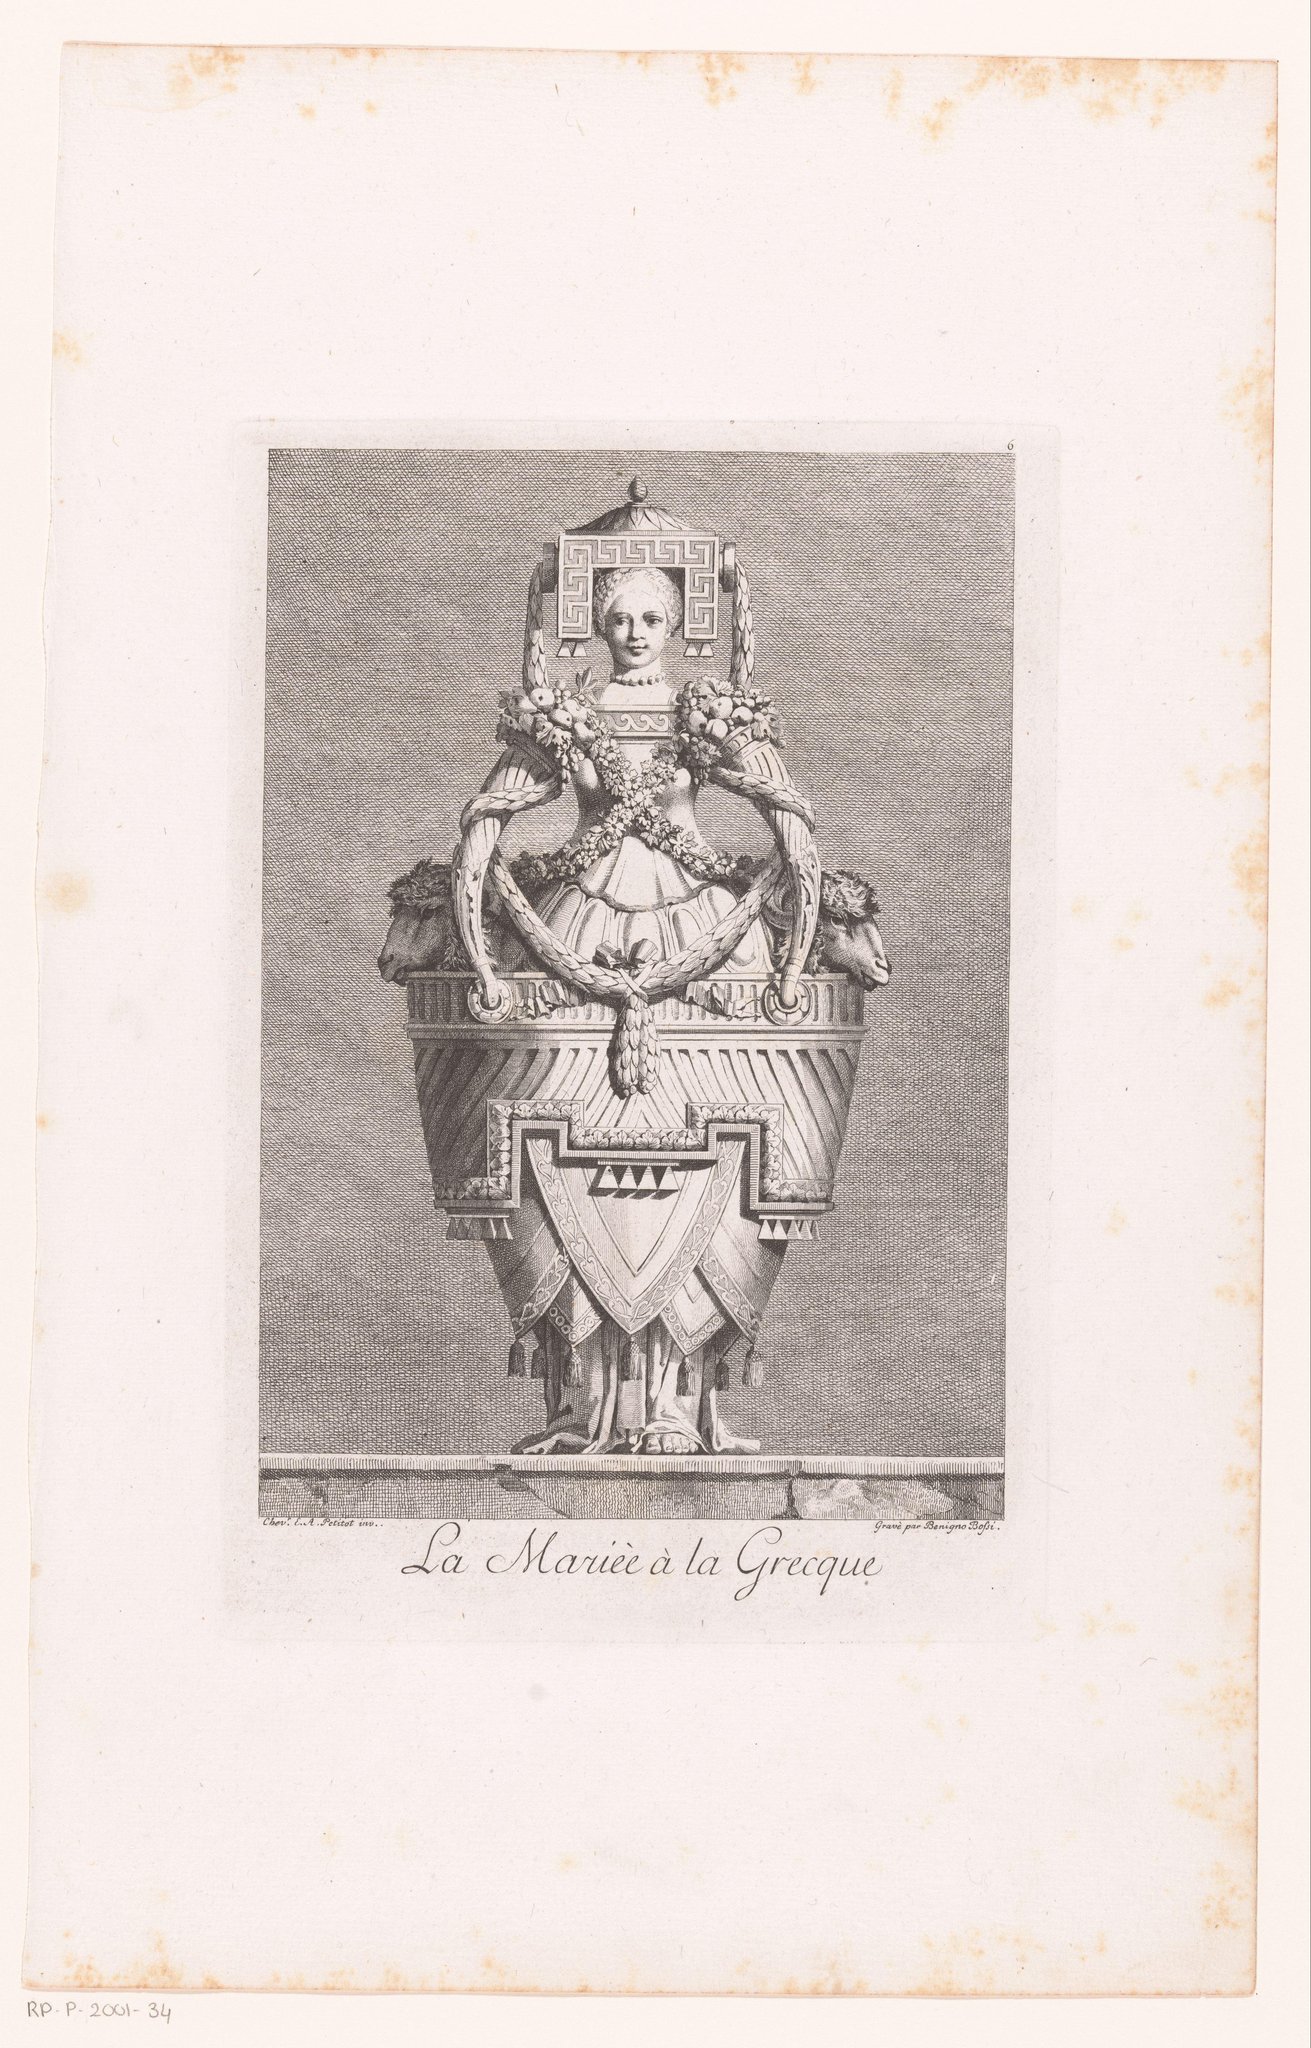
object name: ornament print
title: Mascarade A La Grecque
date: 1771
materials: paper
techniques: etching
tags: europeans, bride (in wedding-dress)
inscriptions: collector's mark: Lugt 2760, collector's mark: Lugt 2228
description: Een staande vrouw met een lijf als een ornamentele vaas gedecoreerd met guirlandes en ramskoppen en armen in de vorm van hoornen des overvloeds. Op haar hoofd een ornament met guirlandes.